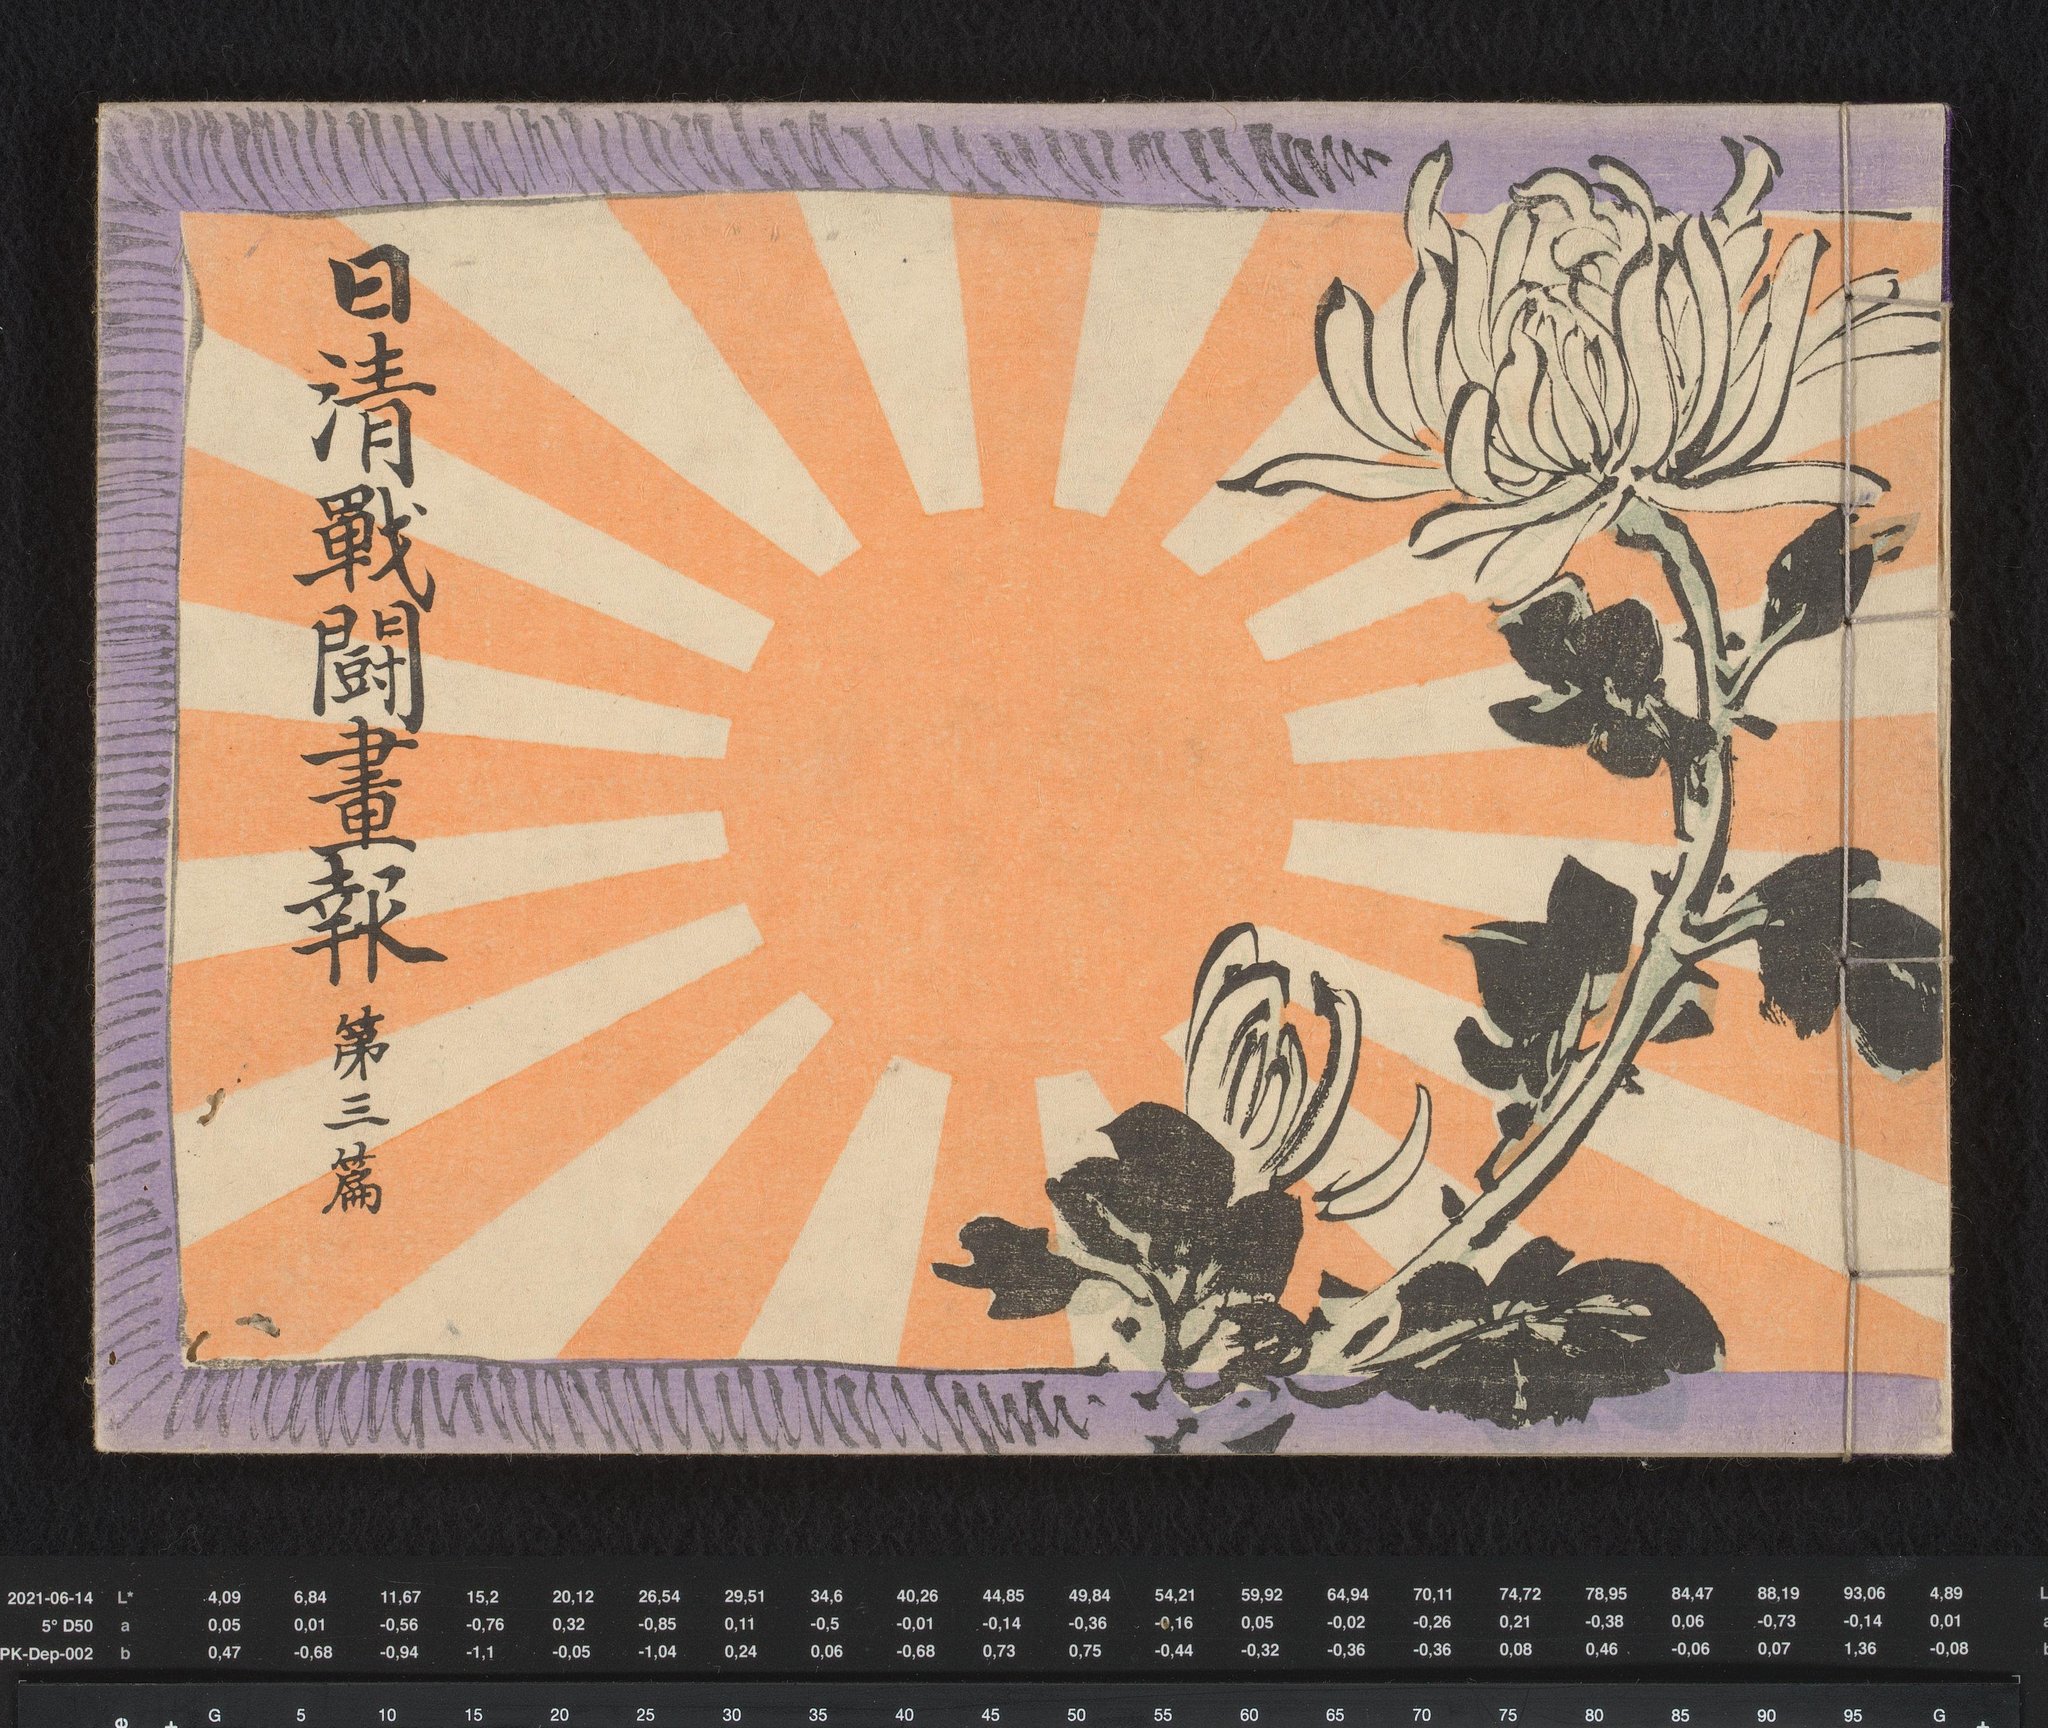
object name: book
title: Geïllustreerd tijdschrift over de Sino-Japanse oorlog - deel 3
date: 1812-1894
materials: paper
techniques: woodcut, letterpress printing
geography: taiwan strait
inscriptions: date